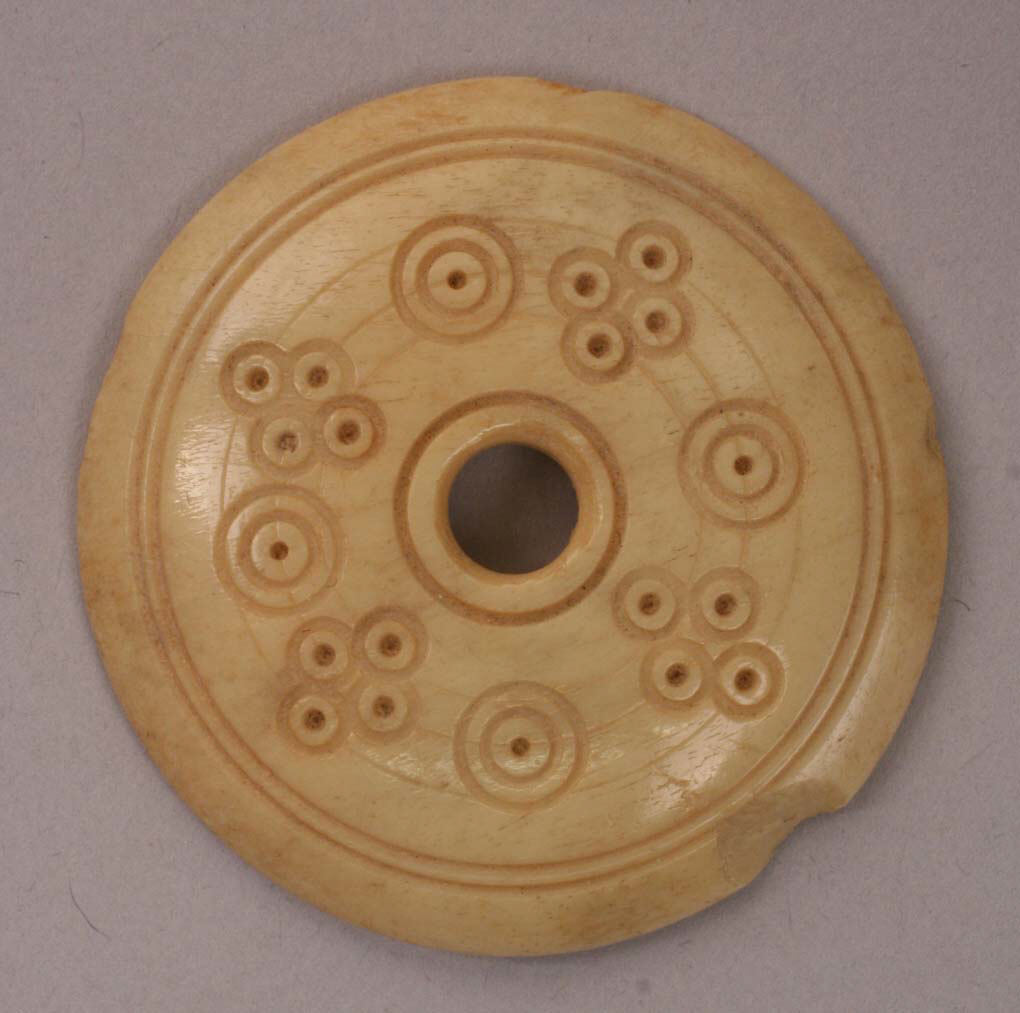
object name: button or spindle whorl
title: Spindle Whorl or Button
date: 401-800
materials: bone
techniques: incising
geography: palestine